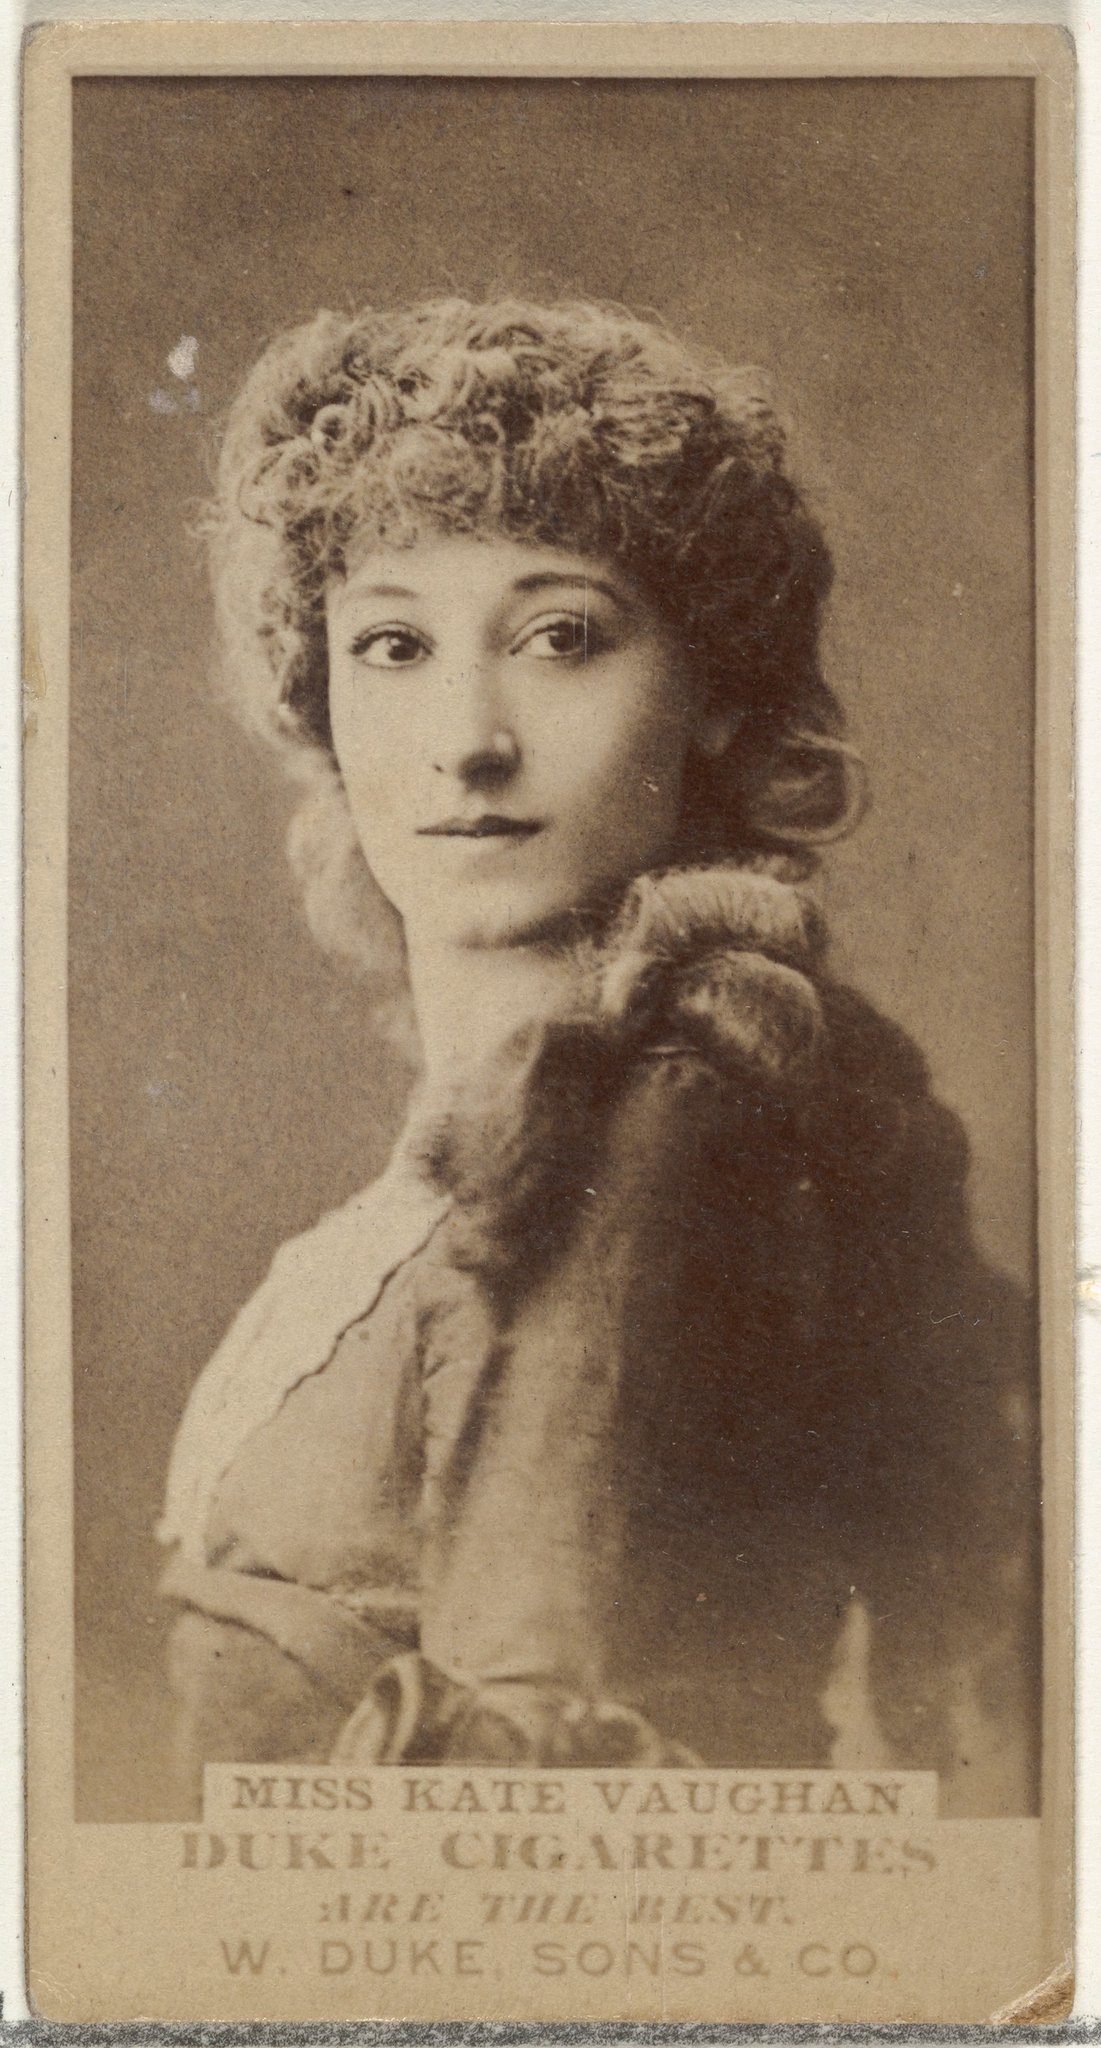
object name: photograph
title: Miss Kate Vaughan, from the Actors and Actresses series (N145-7) issued by Duke Sons & Co. to promote Duke Cigarettes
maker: w. duke, sons & co.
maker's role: publisher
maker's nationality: american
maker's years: 1870-1920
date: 1880-1889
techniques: albumen silver print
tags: portraits,women,actresses